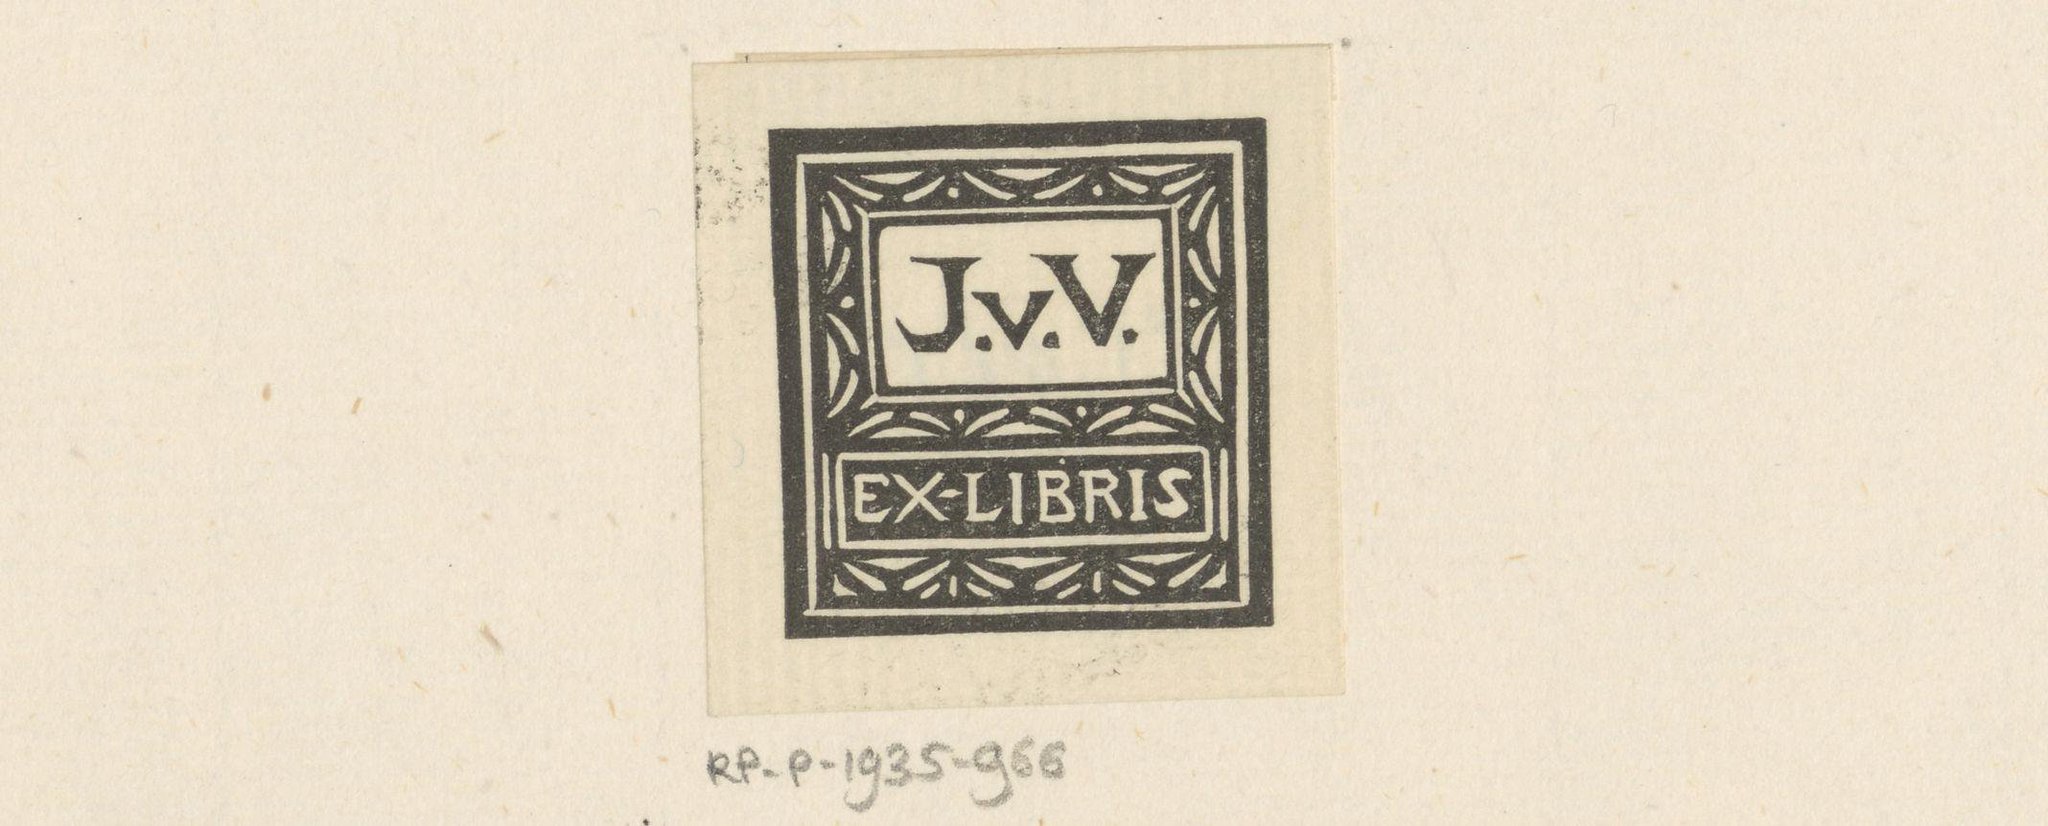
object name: bookplate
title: Ex libris van J.v.V.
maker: julie de graag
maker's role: draughtsman, print maker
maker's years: 1877-1924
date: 1912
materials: paper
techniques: woodcut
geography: netherlands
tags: rotterdam, amsterdam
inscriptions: collector's mark: Lugt 2228